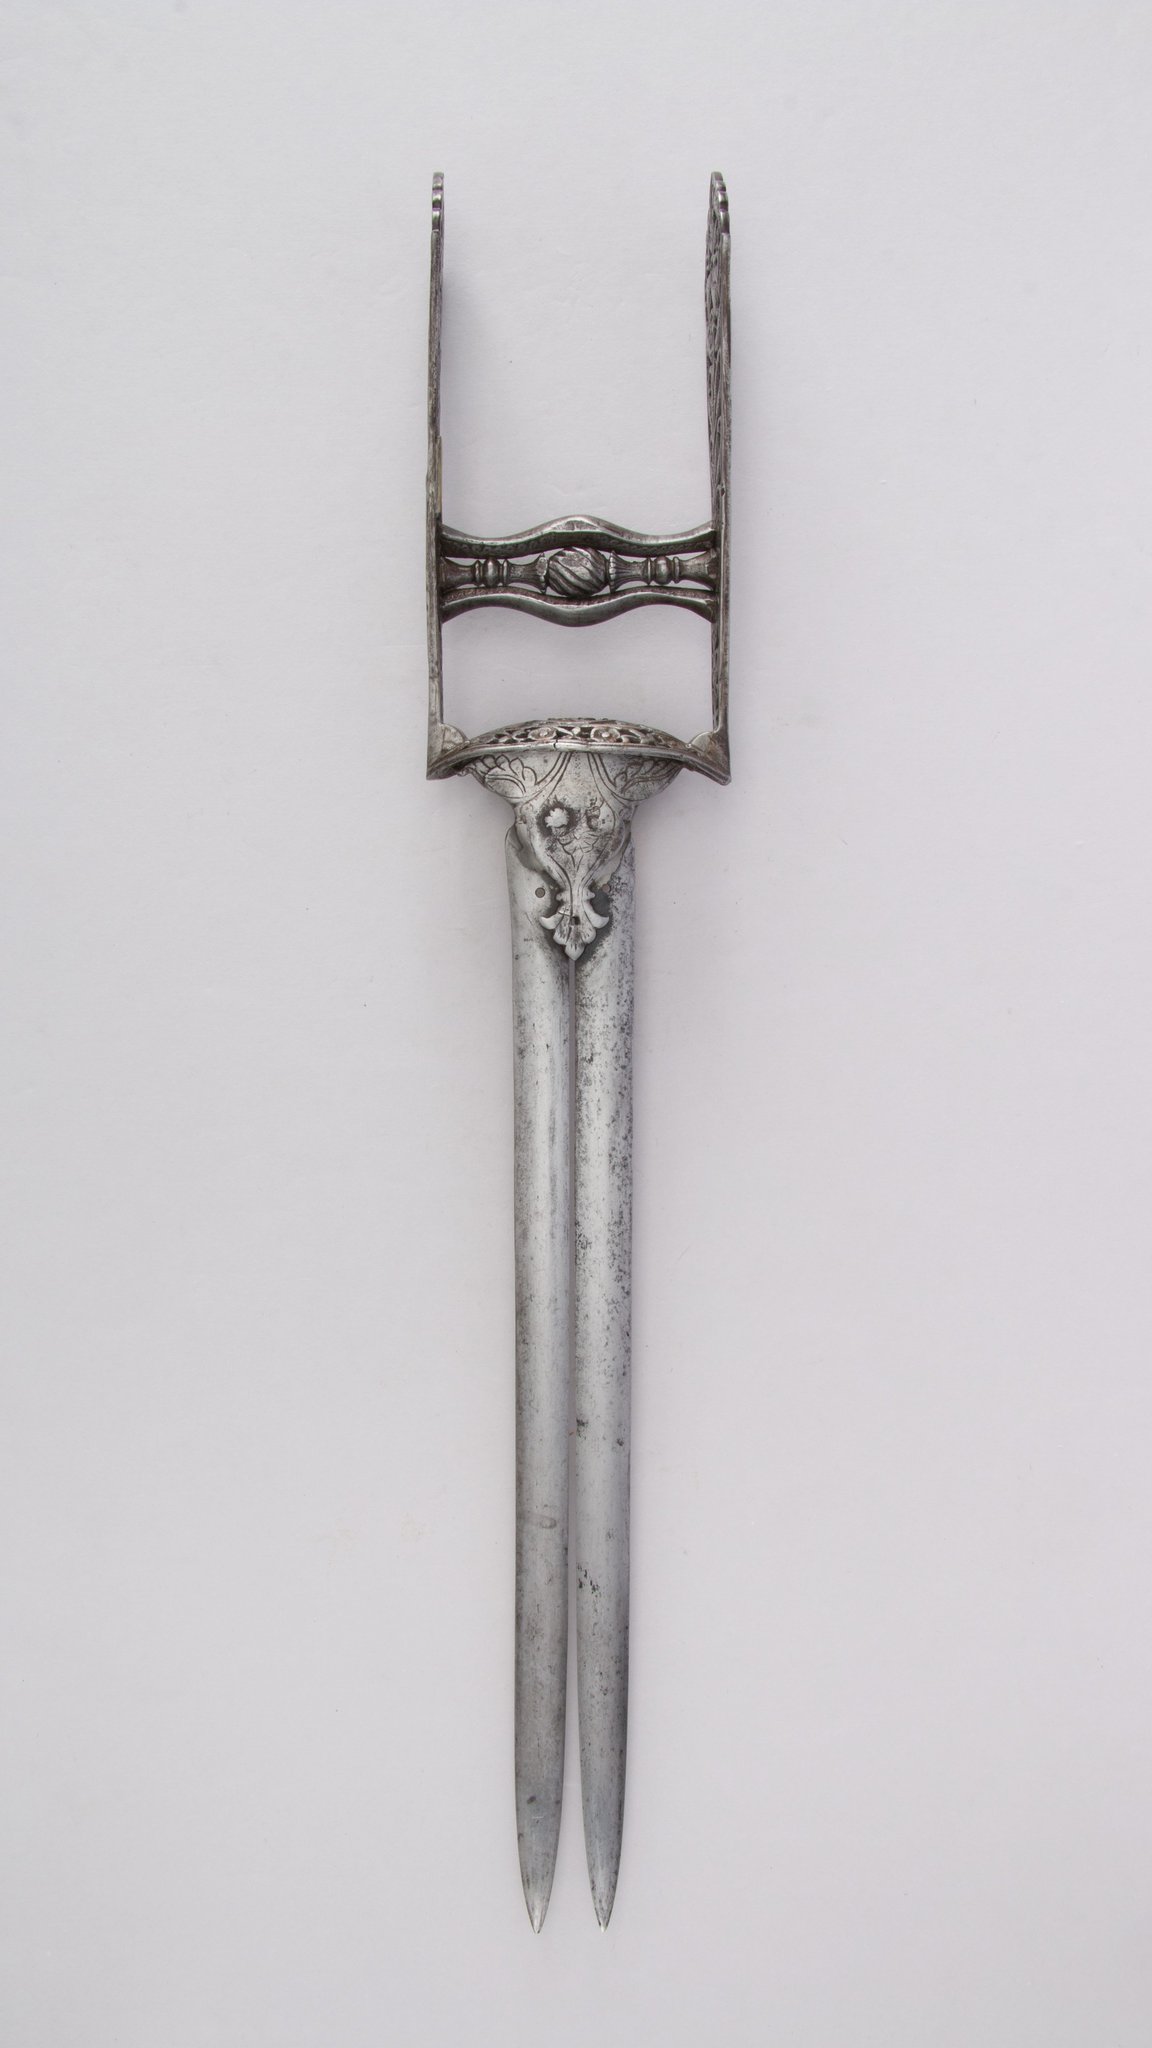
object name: dagger katar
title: Dagger (Katar)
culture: indian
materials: steel